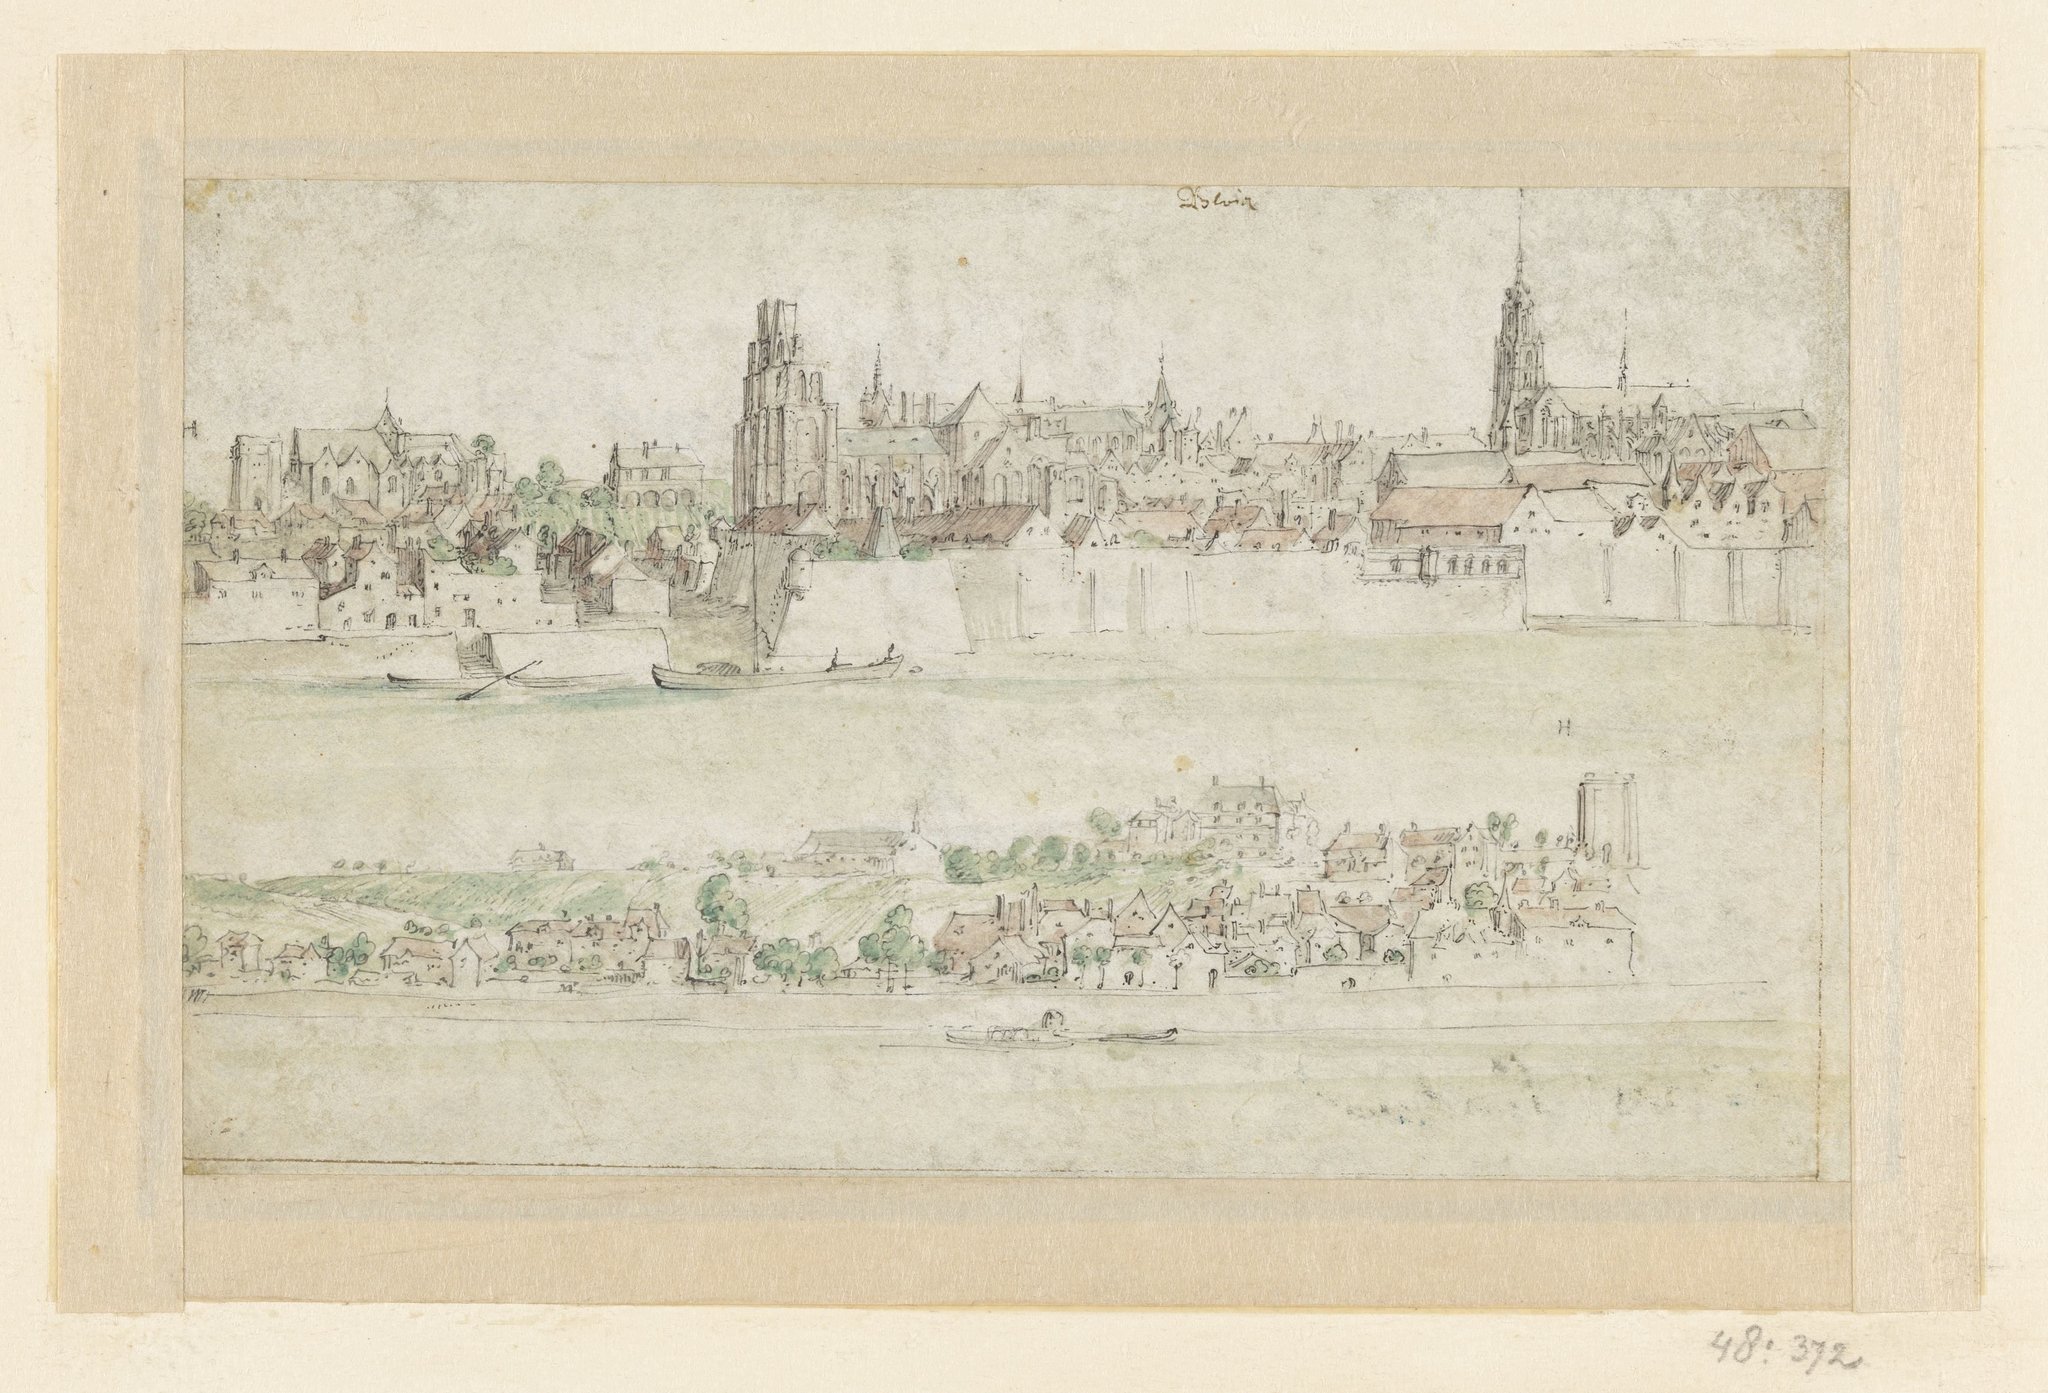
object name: drawing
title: Gezicht op Blois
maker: Anonymous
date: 1600-1650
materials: ink, parchment, watercolor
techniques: brush, pen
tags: city-view in general; 'veduta' (+ city(-scape) with figures, staffage), canals, waters (in city) (+ city(-scape) with figures, staffage)